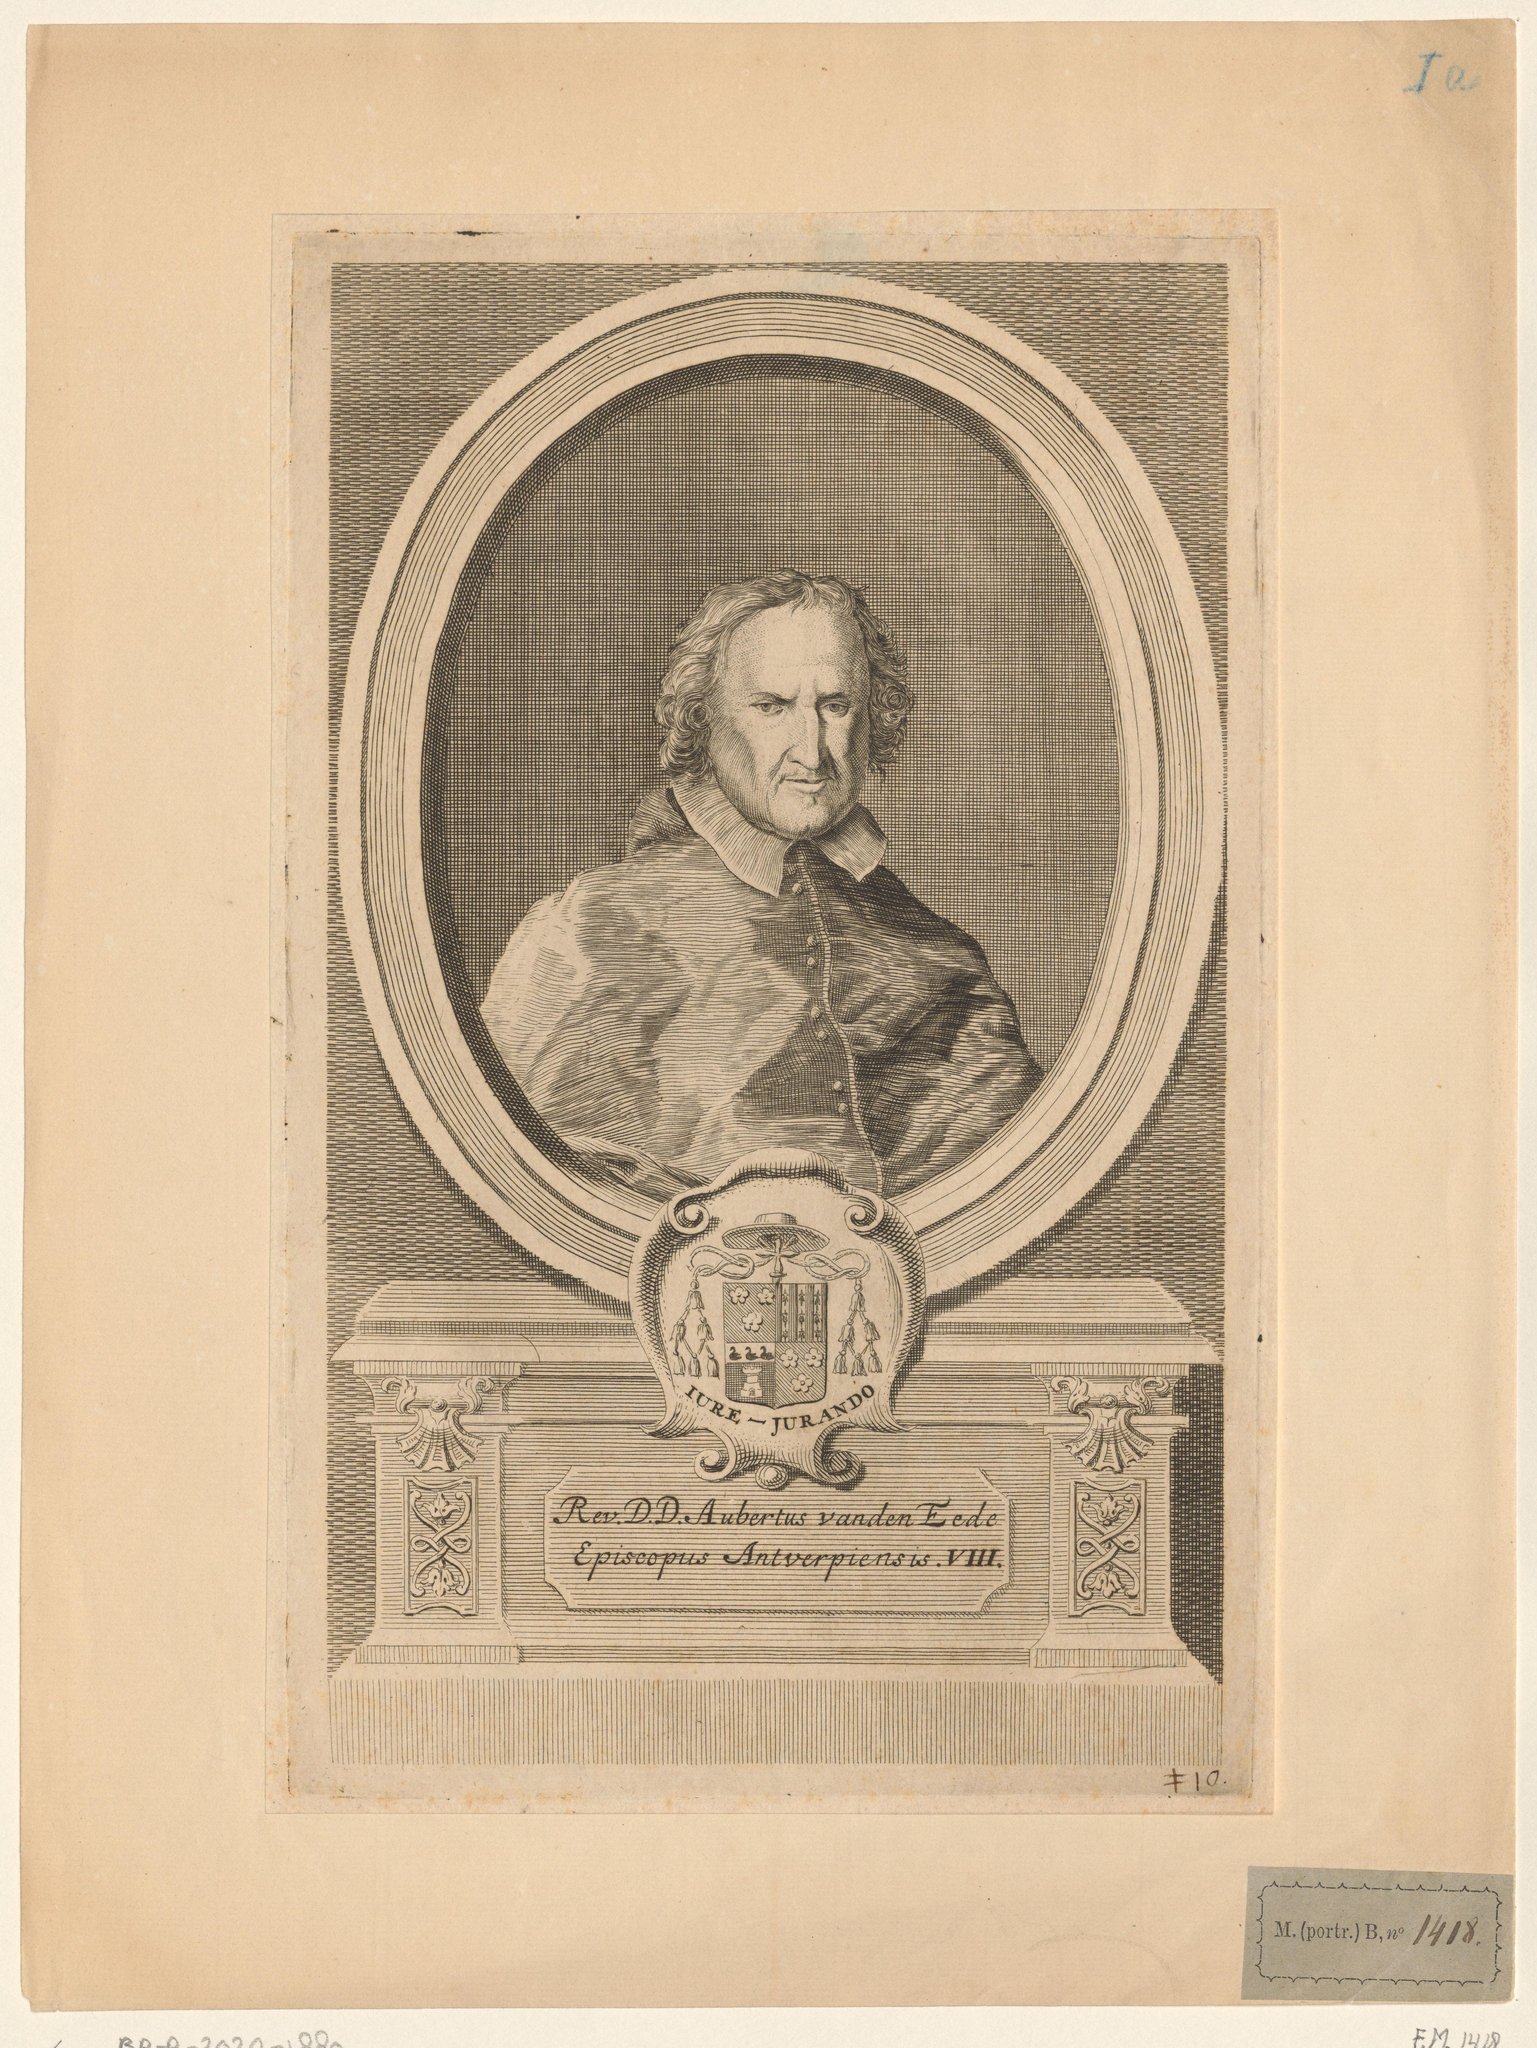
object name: print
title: Portret van Aubertus van den Eede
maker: jan baptist jongelinx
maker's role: print maker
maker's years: 1689-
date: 1727-1734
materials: paper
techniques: engraving, etching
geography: antwerp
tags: brussels, antwerp, aubertus van den eede, archbishop, bishop, etc. (roman catholic), historical persons, armorial bearing, heraldry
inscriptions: collector's mark: Lugt 2228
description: Prent waarschijnlijk uit: Roy, Jacques le. Groot kerkelijk tooneel des Hertogdoms van Brabant (...). Den Haag: Christiaan van Lom, 1727. Of uit de Franse editie van het werk, gepubliceerd in 1734.